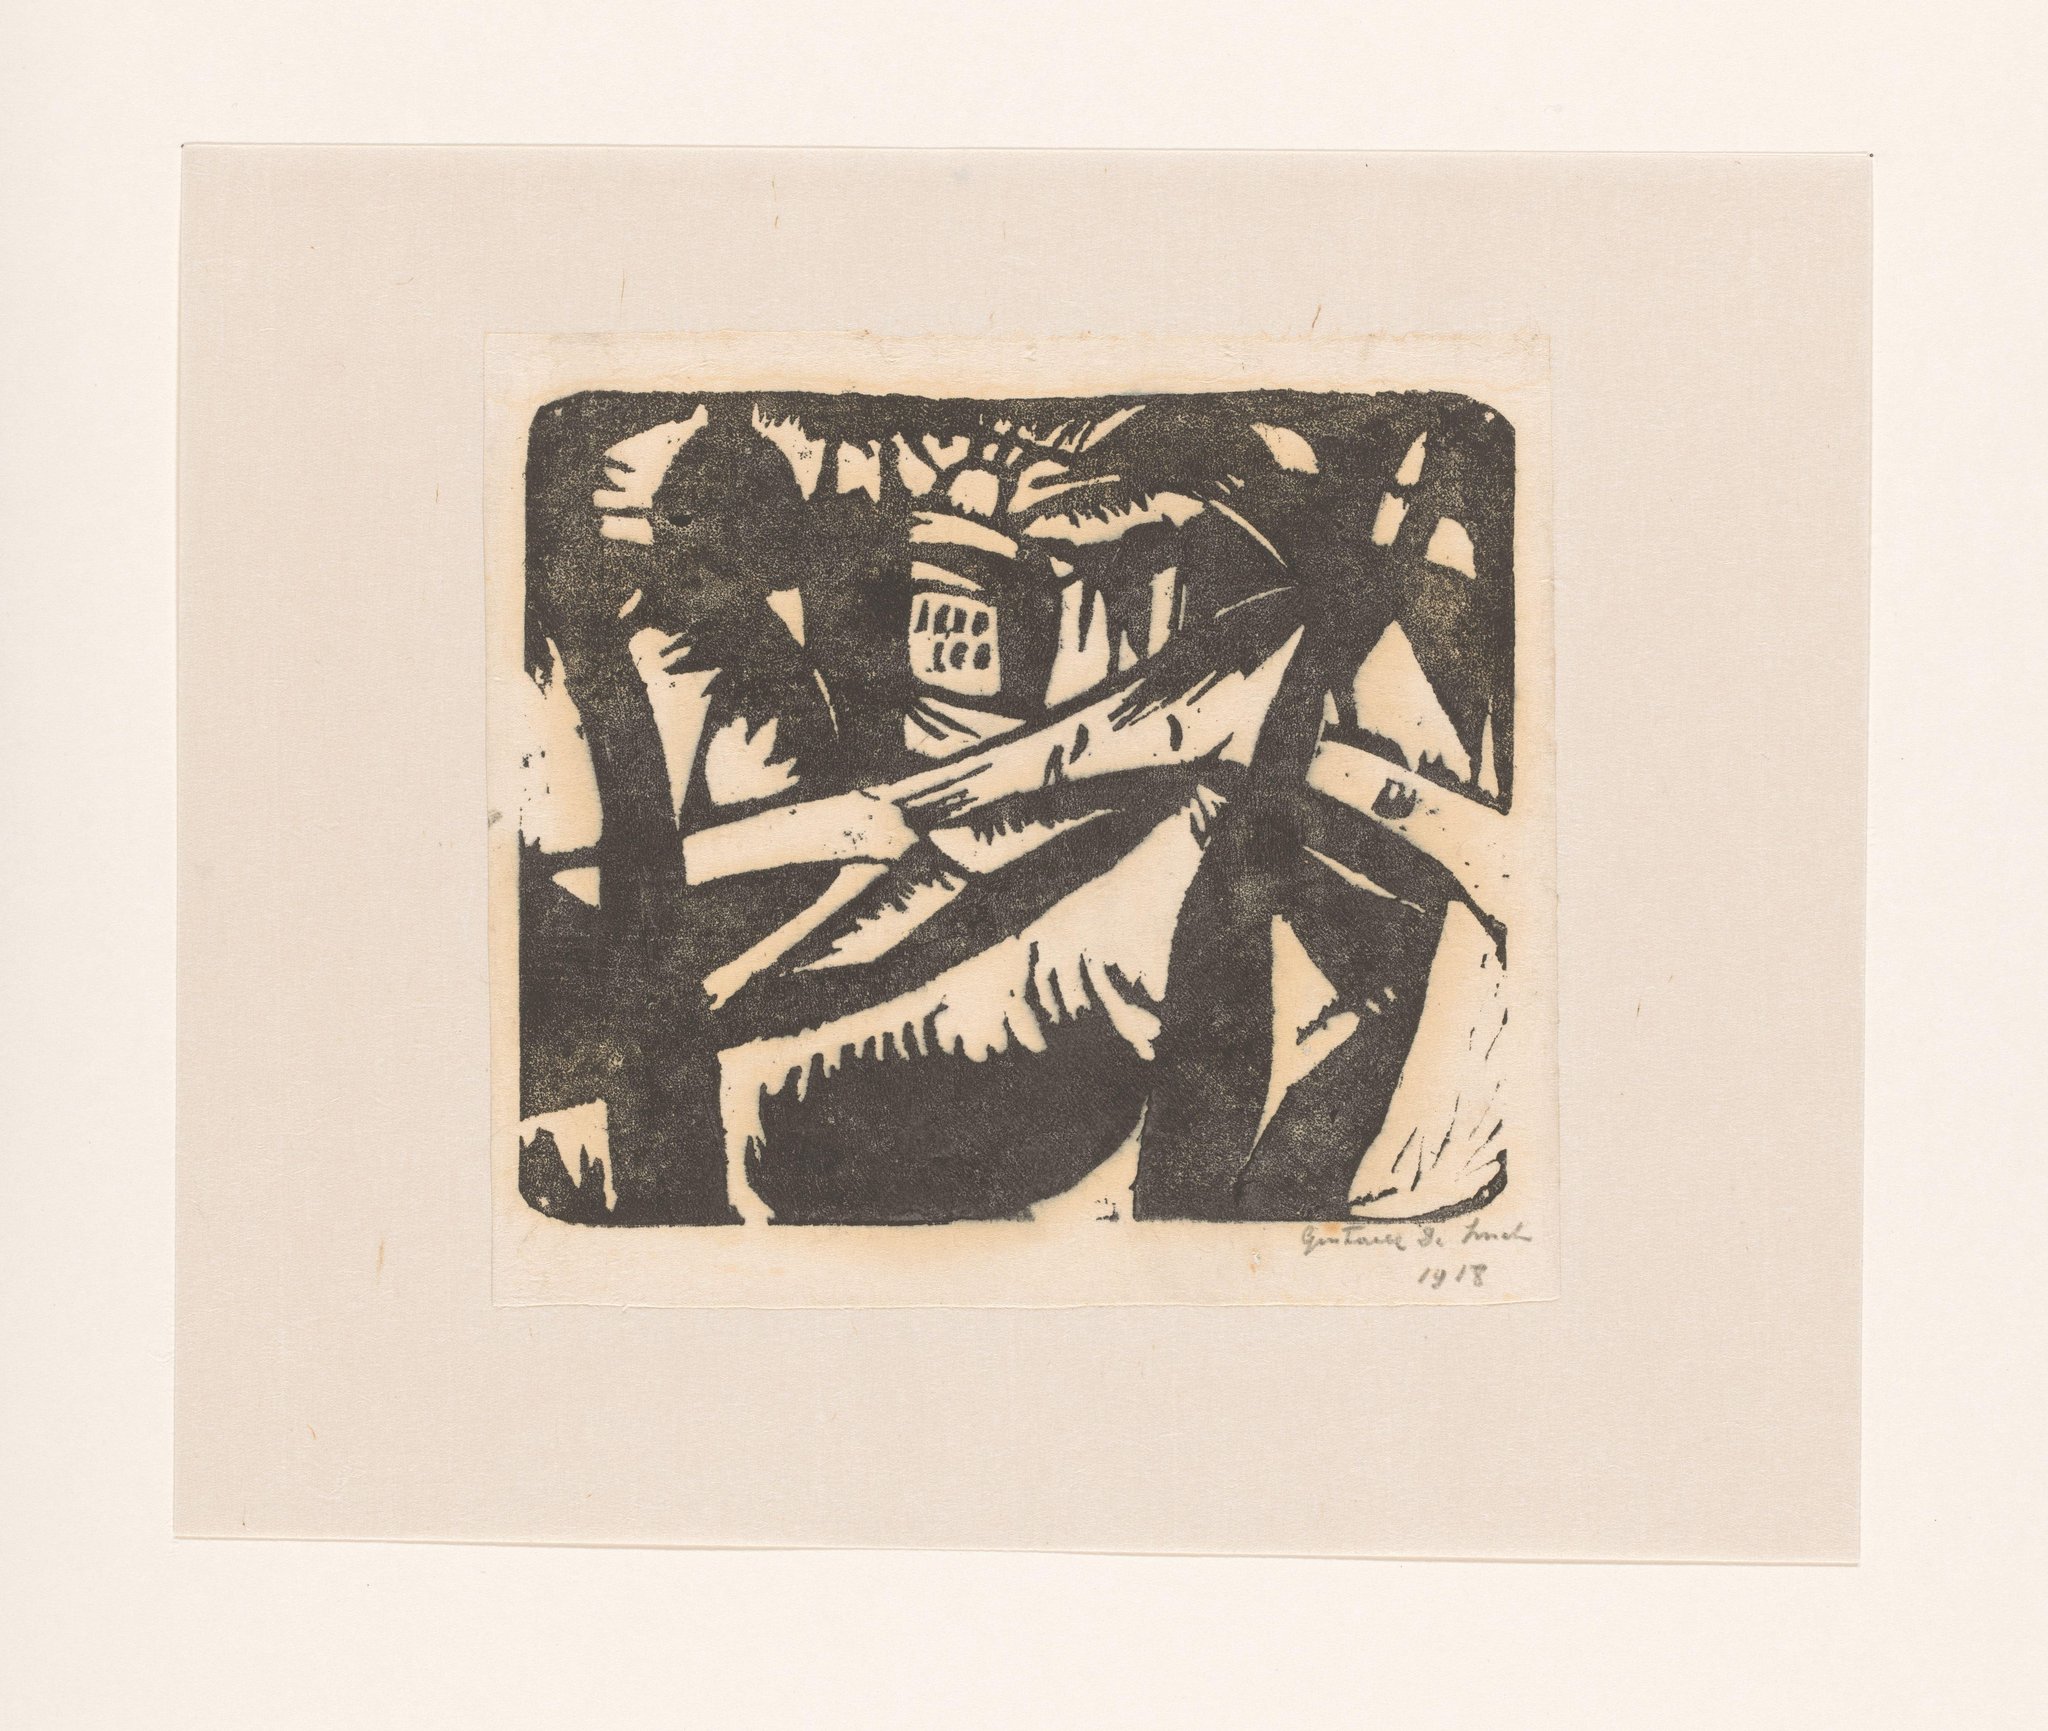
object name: print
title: Landschap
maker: gustave de smet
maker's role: print maker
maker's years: 1877-1943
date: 1918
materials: paper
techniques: woodcut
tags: landscapes in the temperate zone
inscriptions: collector's mark: Lugt 2228